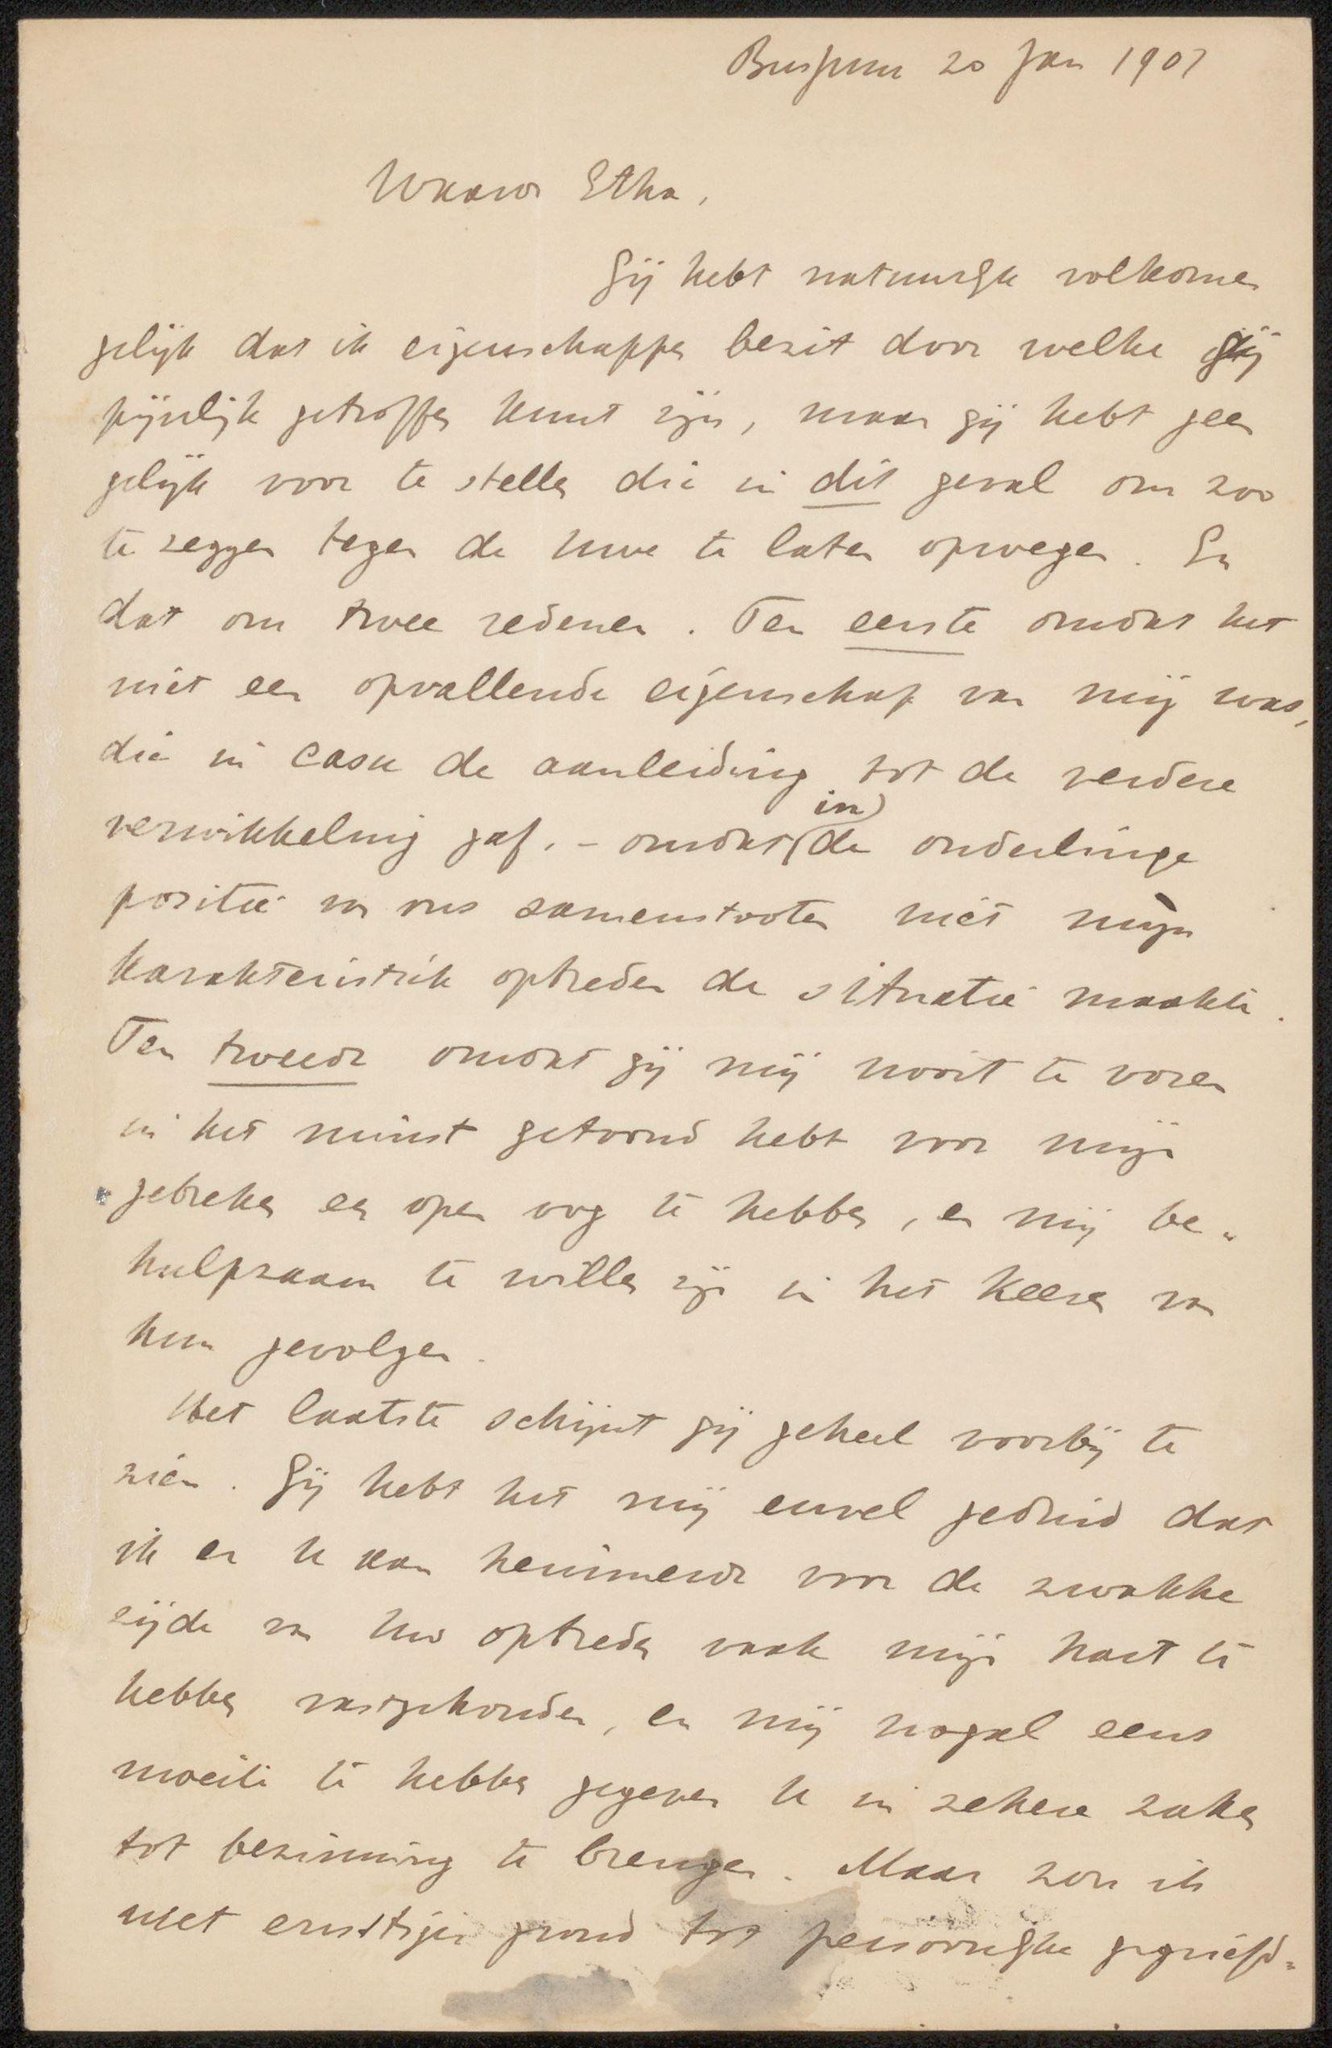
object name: letter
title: Brief aan Etha Fles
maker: jan veth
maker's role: designer, draughtsman, painter, print maker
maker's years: 1864-1925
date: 1901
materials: ink, paper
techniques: pen, writing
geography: bussum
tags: utrecht, print maker, etha fles, passions, emotions, affections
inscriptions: collector's mark: ‘RPK’